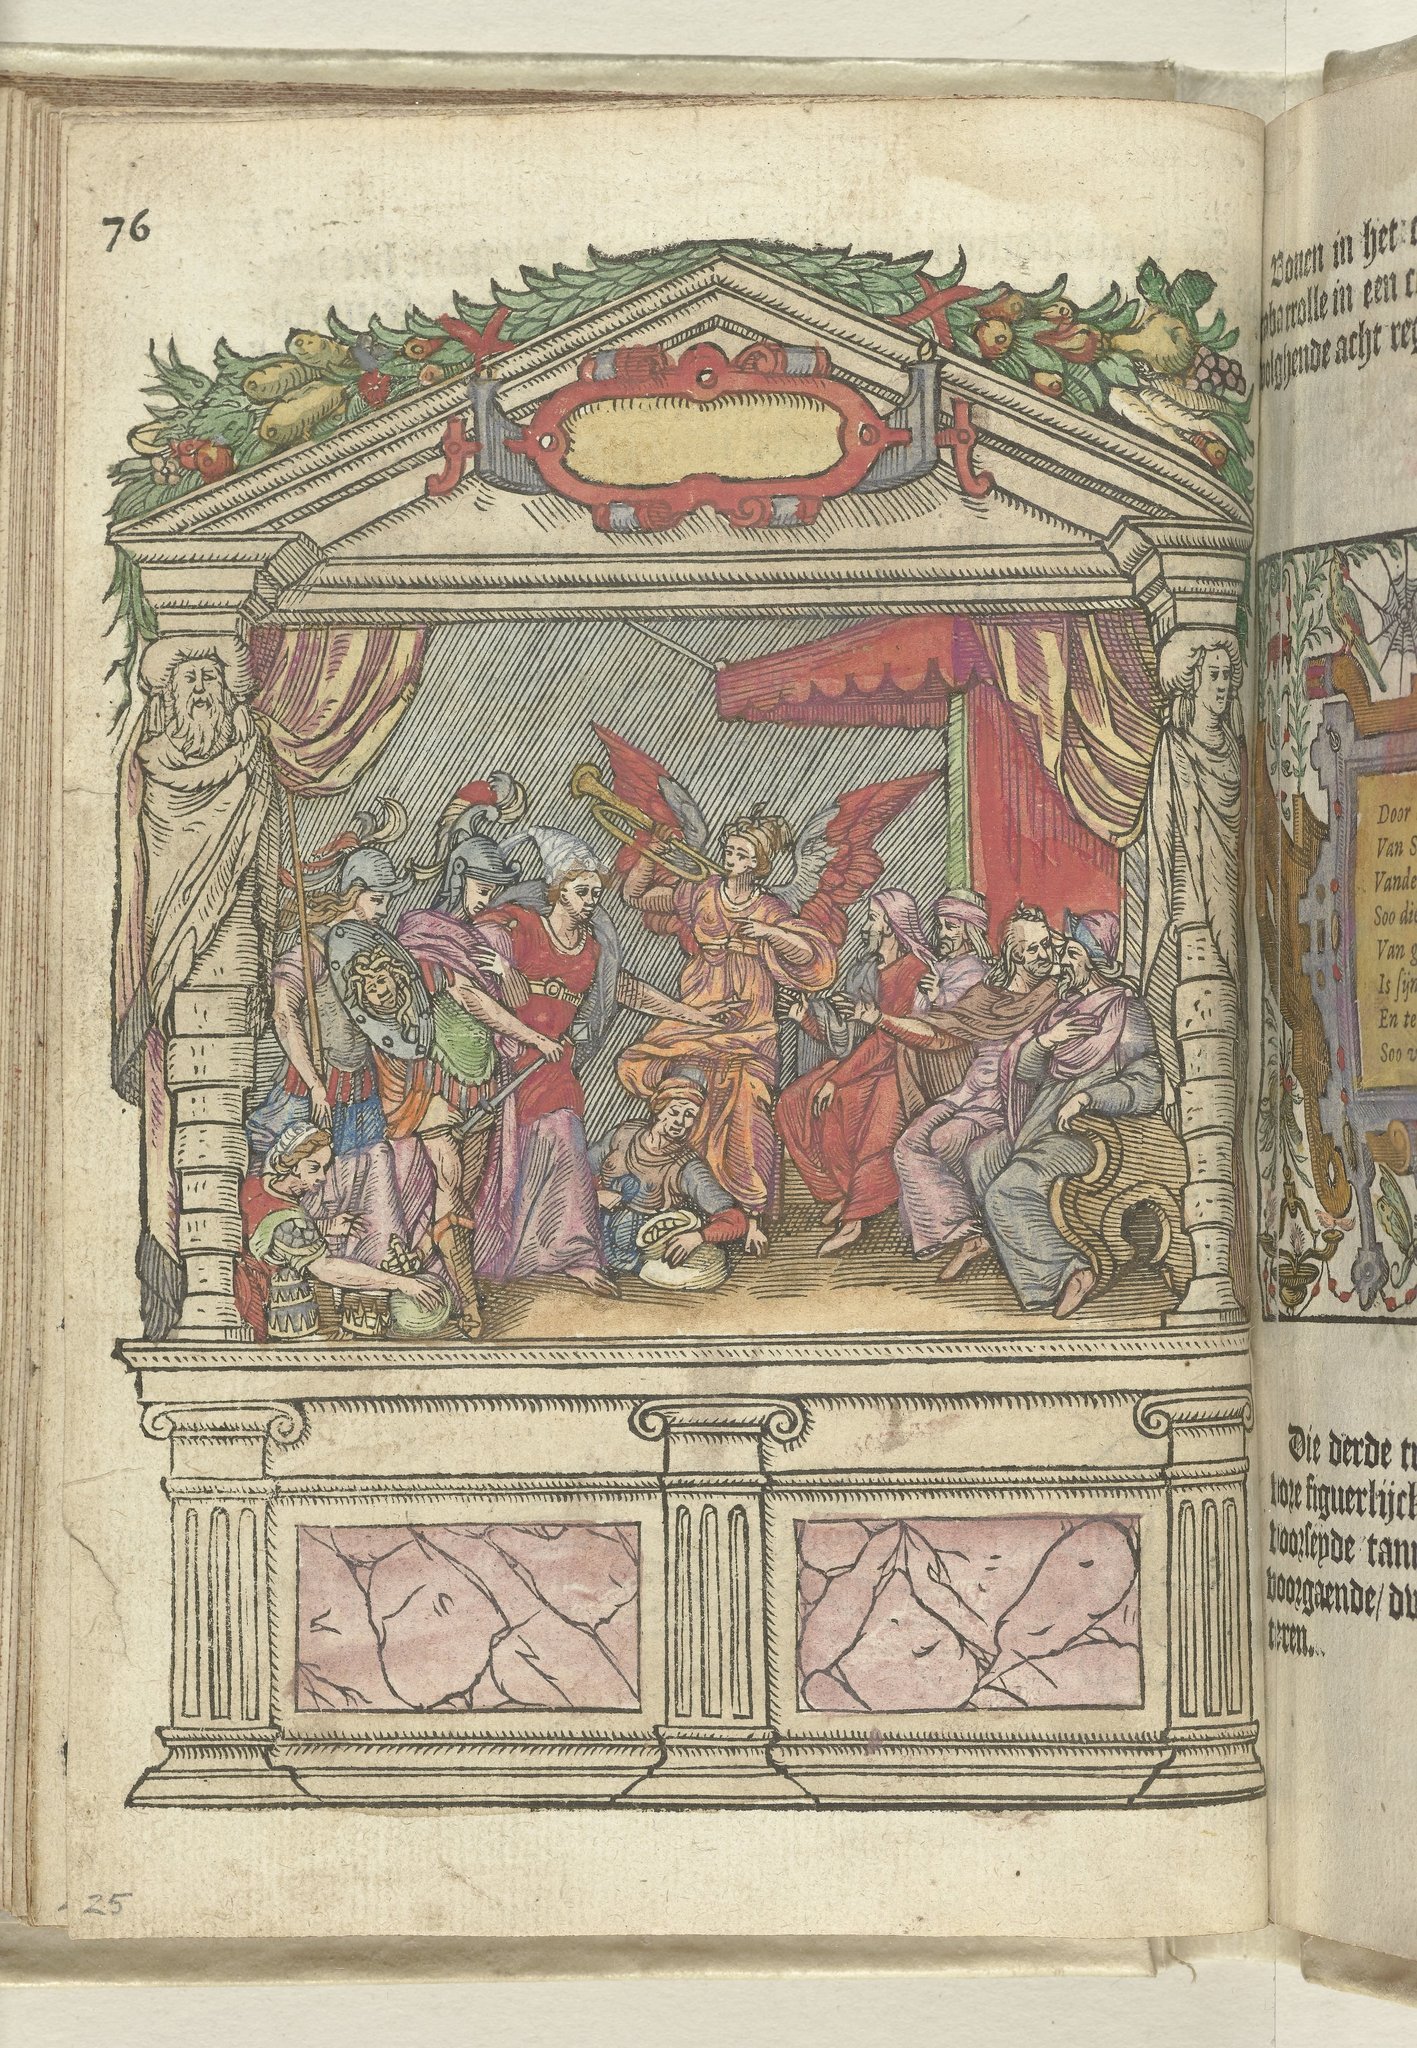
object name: print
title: Toneel met allegorische voorstelling bij de Grote Markt, 1578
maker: antoni van leest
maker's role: print maker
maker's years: 1545-1592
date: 1578-1579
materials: paper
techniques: hand coloring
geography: antwerp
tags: vienna, matthias van oostenrijk (rooms-duits keizer), group of actors, troupe; actors on the stage, triumphal entry and public reception, pageant, 'entrée solennelle', 'joyeuse entrée', (story of) p. cornelius scipio africanus major, brussels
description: Illustratie in: J.B. Houwaert, Sommare beschrijvinghe vade triumphelijcke Incomst van den doorluchtighen ende hooghgheboren /Aerts-hertoge Matthias binnen die Prinelijcke stadt van Brussele, in 't iaer ons Heeren 1578 den XVIII dach Januarij... Gheinventeert ende ghecomponeert deur Jean Baptista Houwaert, Christoffel Plantijn, Antwerpen 1579. Boek in de Rijksmuseum Research Library met signatuur: 327 K 2.